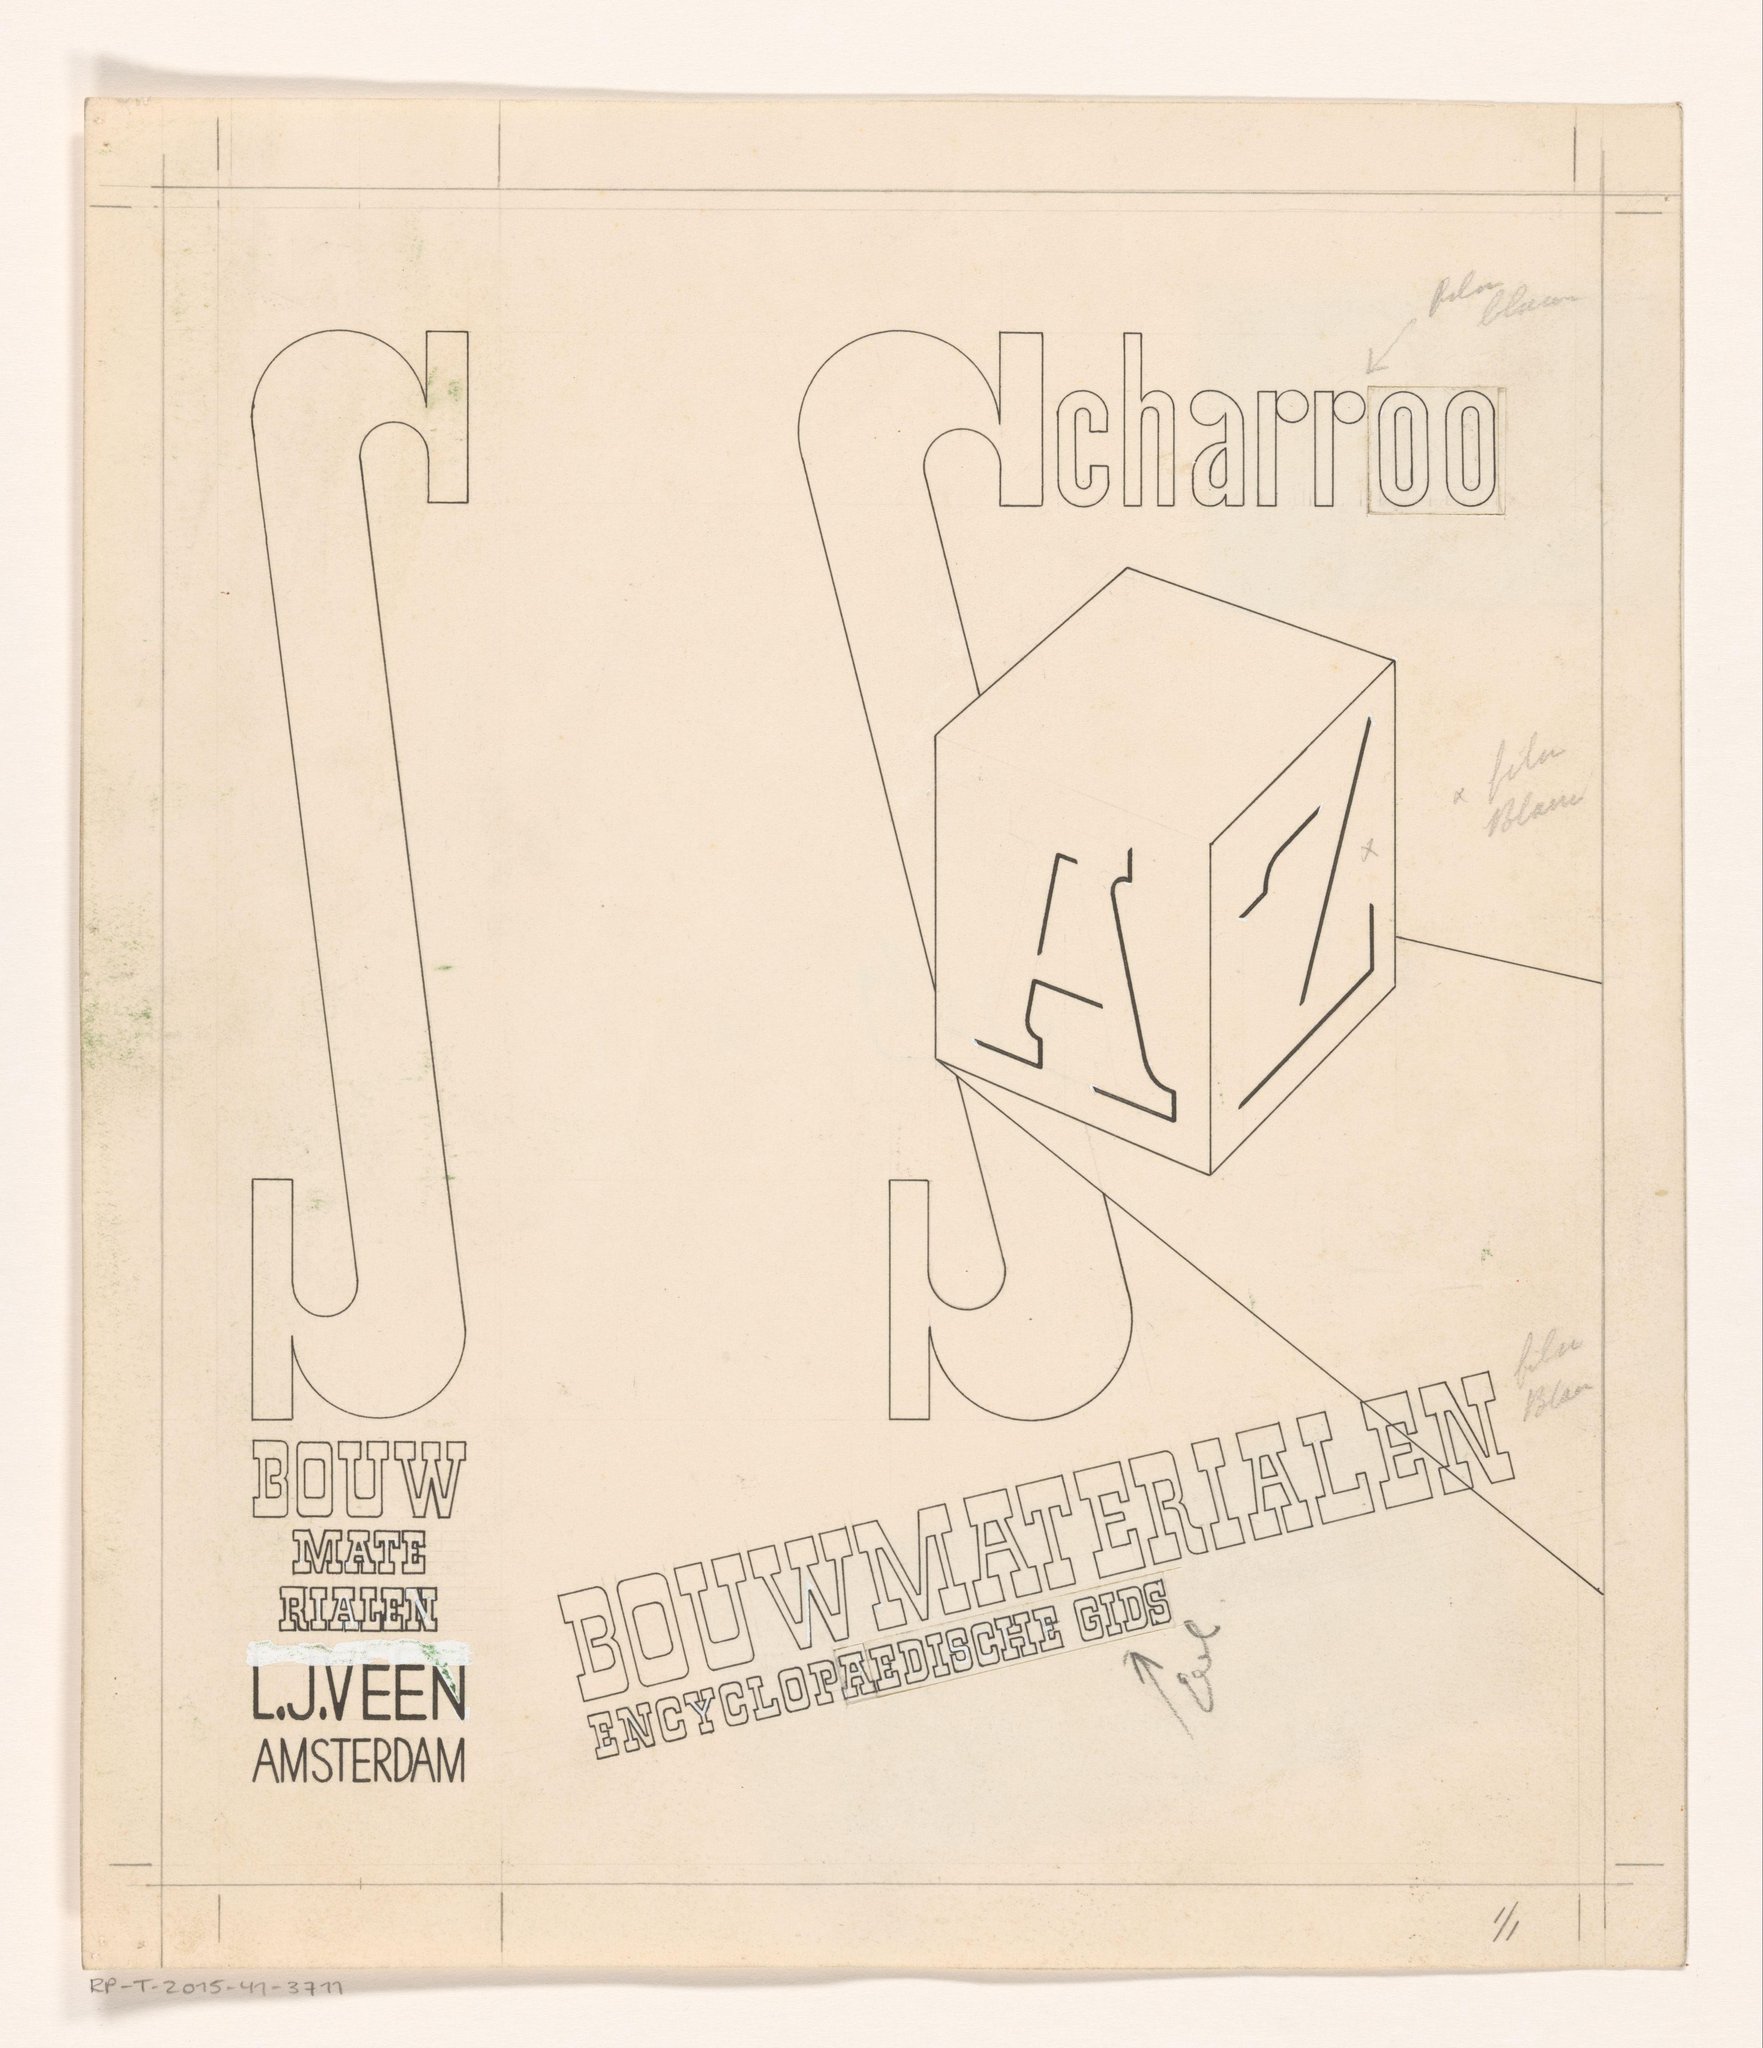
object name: study for binding design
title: Bandontwerp voor: P.W. Scharroo, Bouwmaterialen. Encyclopaedische gids voor theorie en praktijk, c. 1943-1944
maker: Anonymous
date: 1943-1944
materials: paint, ink, paper, pencil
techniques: brush, pen, snipping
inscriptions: :, collector's mark: Lugt 2228a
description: Uitvergrote hoofdletter 'S' van de naam 'Scharroo' met een kubus met op de ene zijde een 'A' en de andere zijde een 'Z'. Op de boekrug tevens een uitvergrote hoofdletter 'S'.